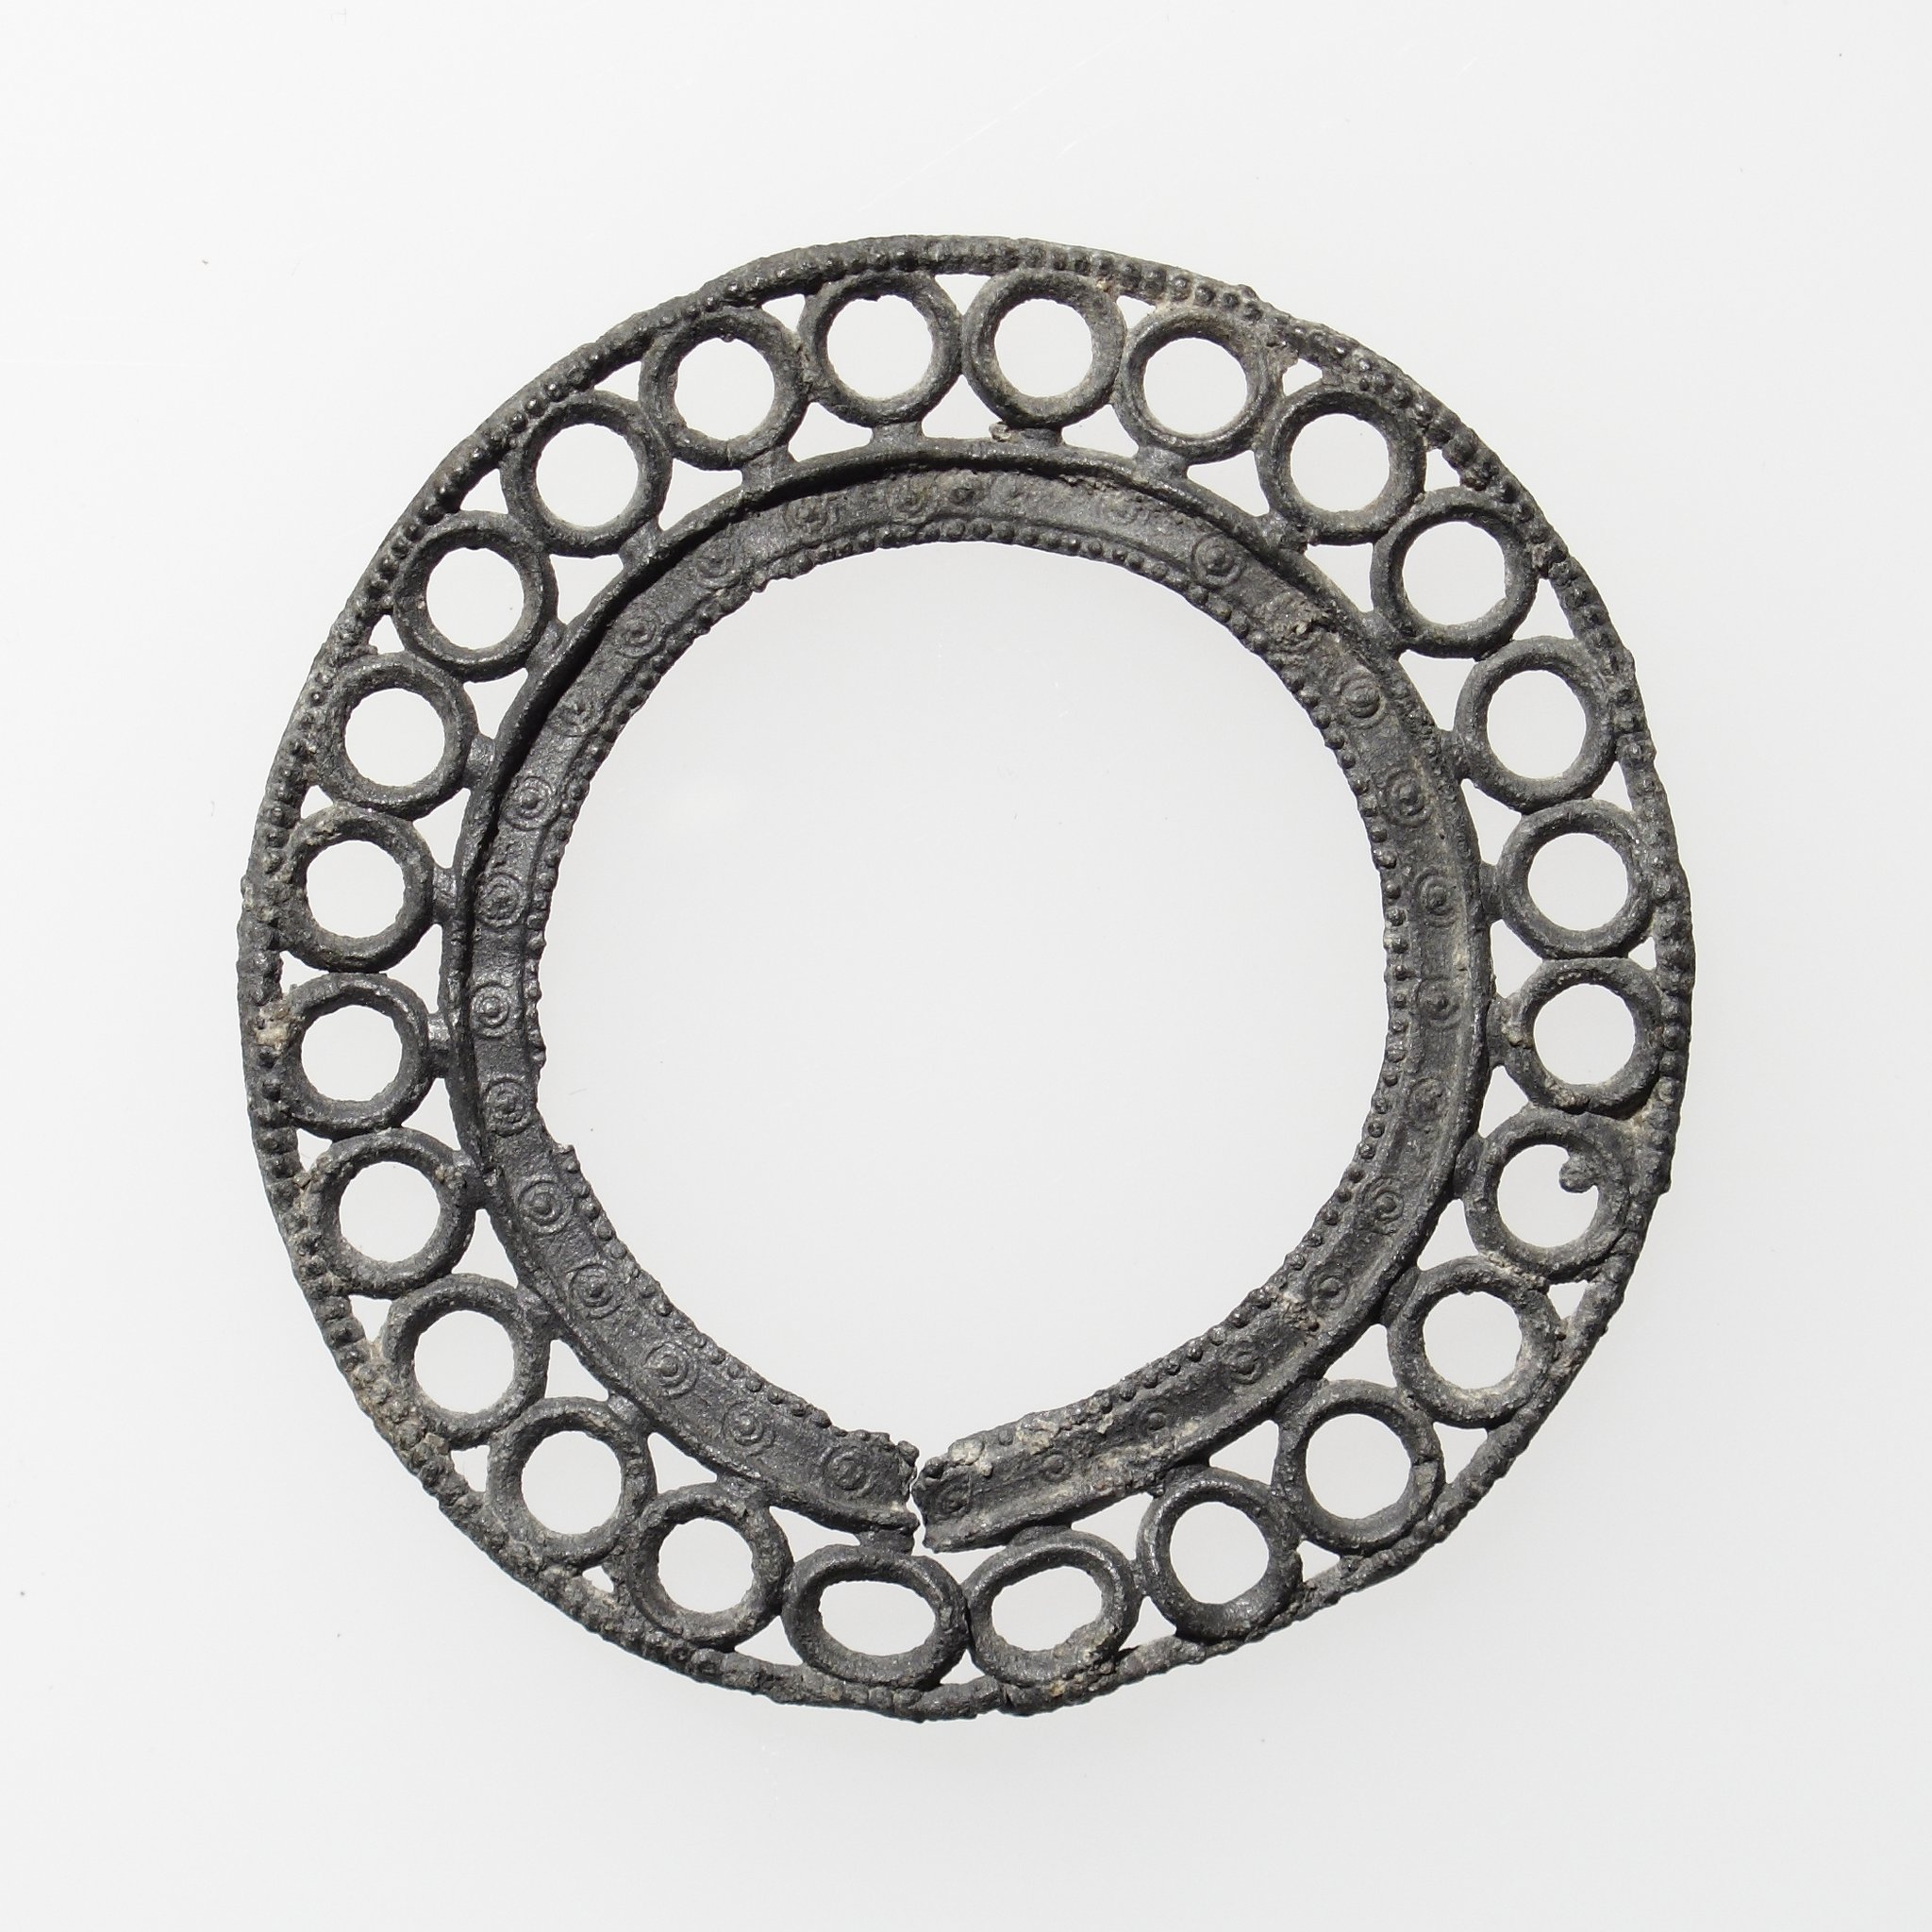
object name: pilgrim's badge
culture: french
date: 1301-1600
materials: lead